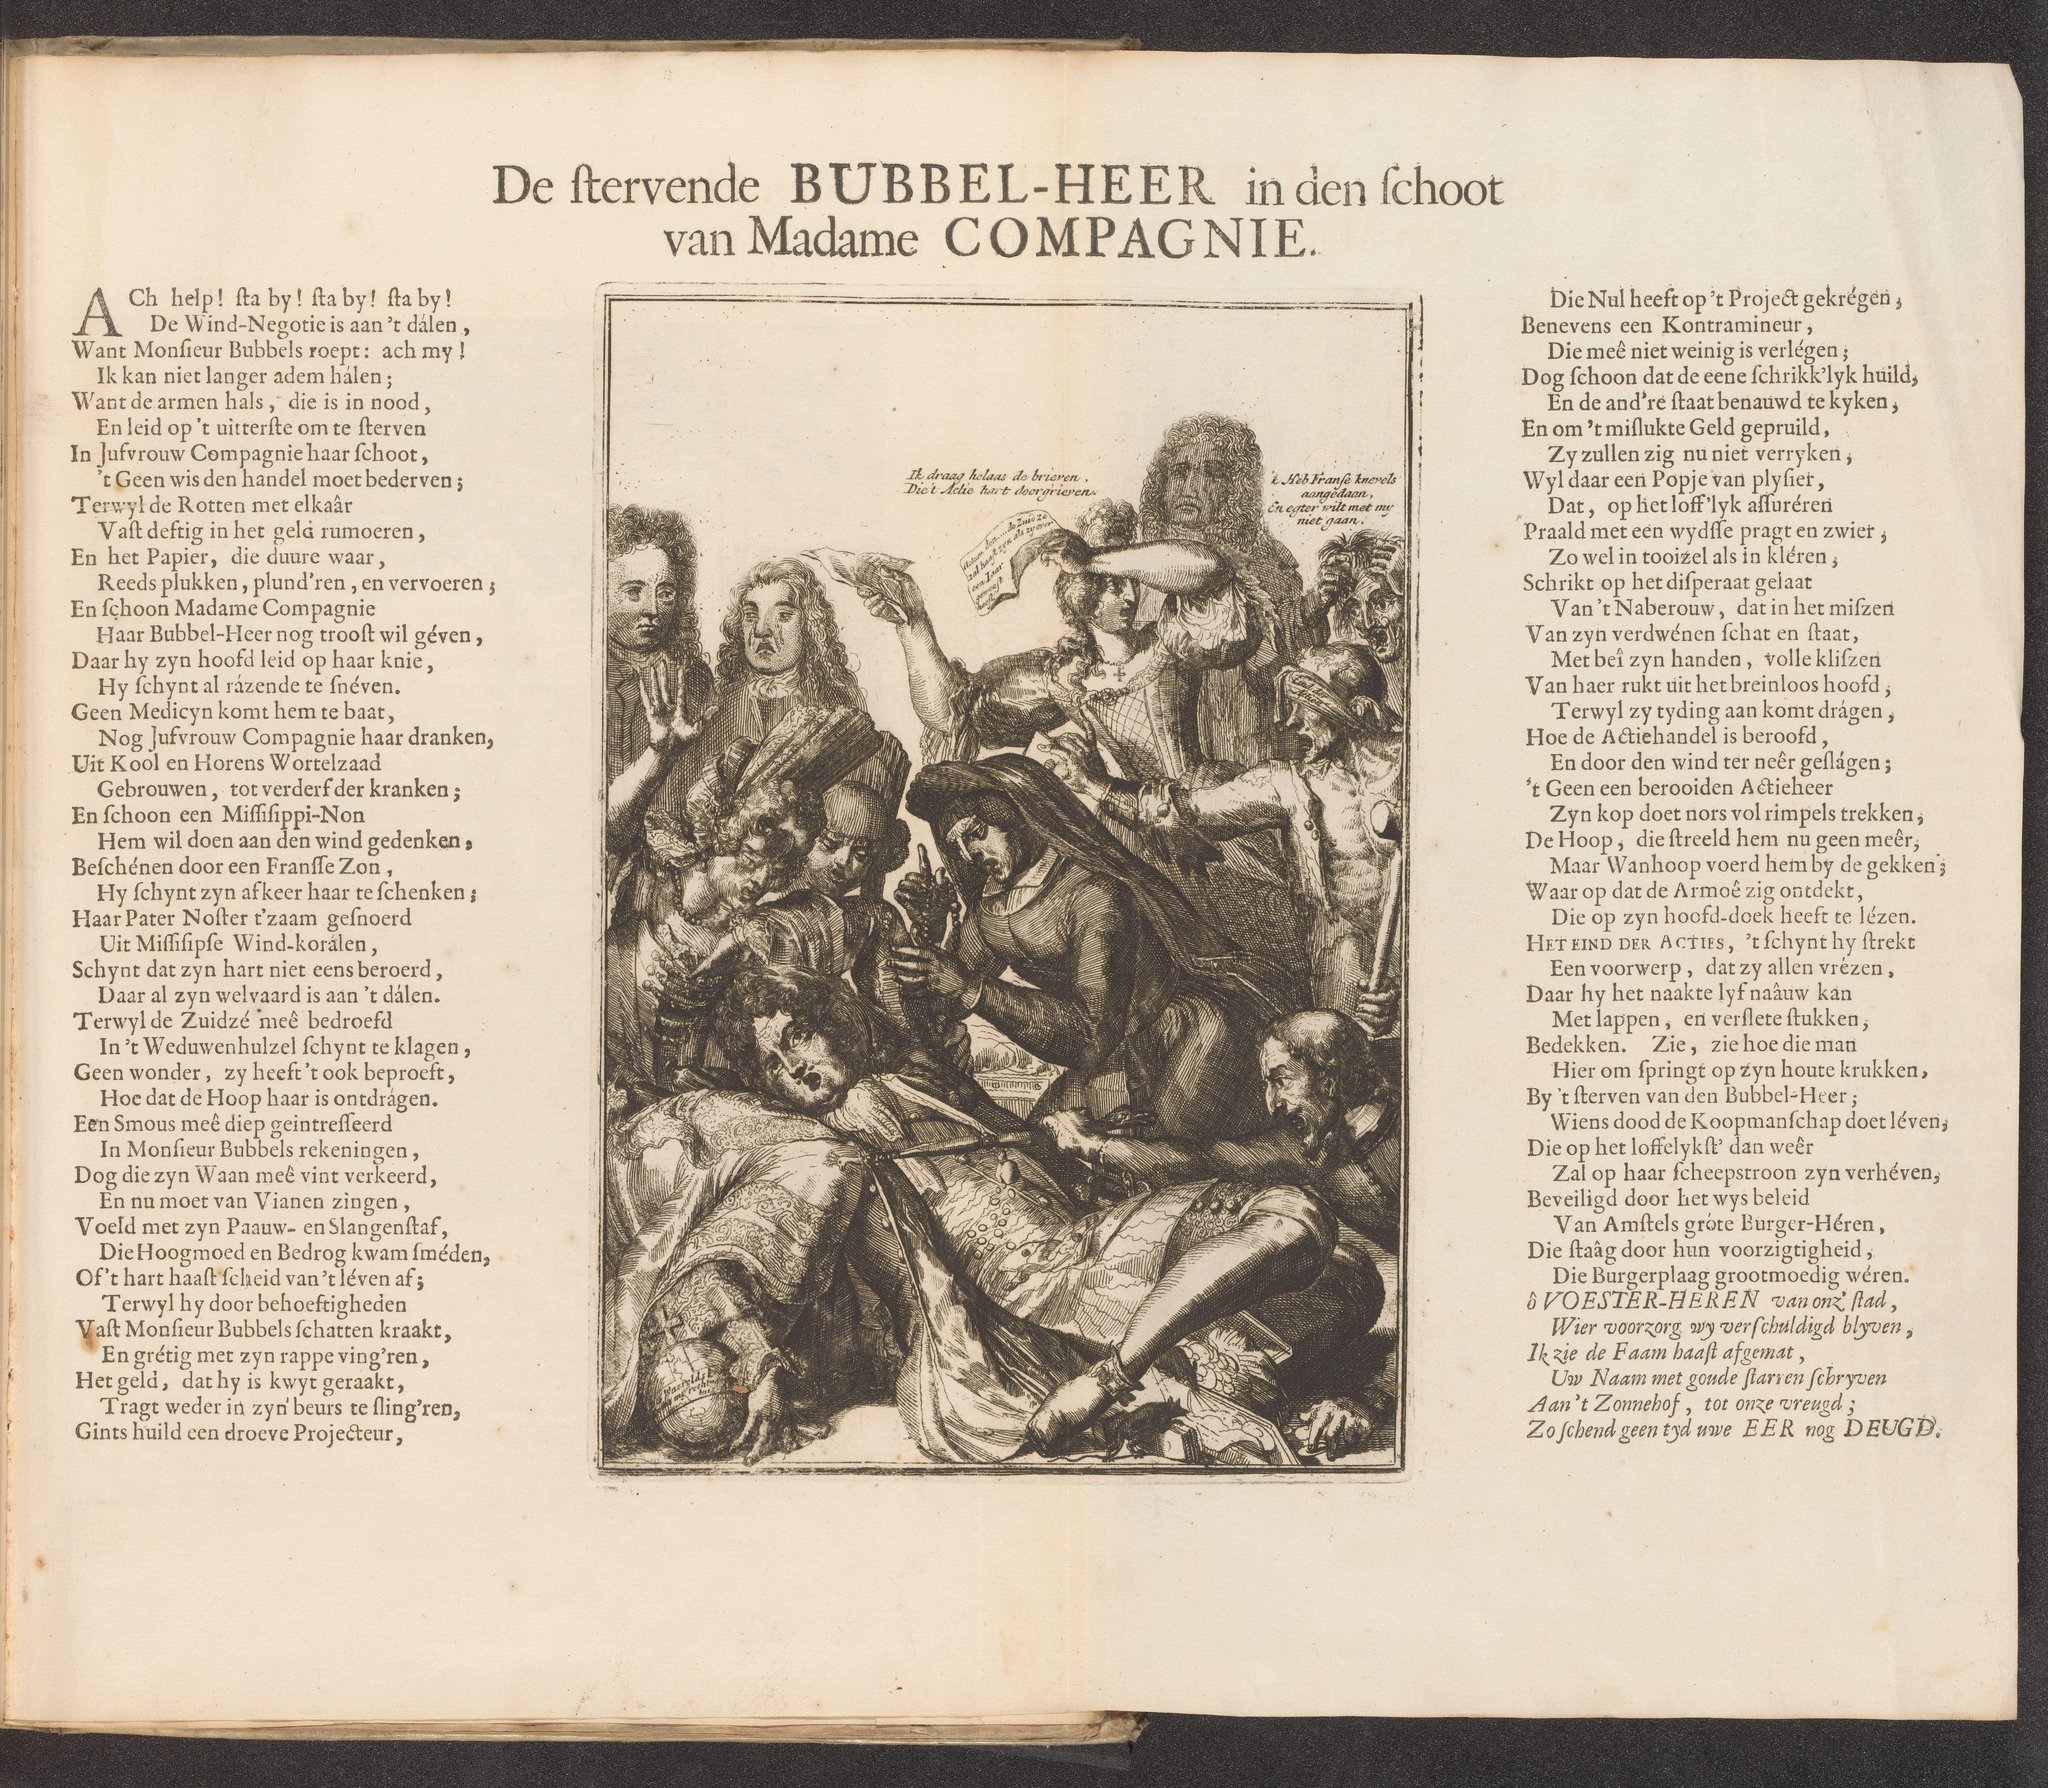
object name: cartoon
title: De stervende Bubbel-Heer in den schoot van Madame Compagnie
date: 1706-1707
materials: paper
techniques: etching, letterpress printing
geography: southern netherlands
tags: patient, sick person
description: De stervende windhandelaar of bubbelheer John Law achterover liggend in de schoot van Madame Compagnie wordt getroost door een non en een biechtvader. Met een vers aan weerszijden van de plaat. Prent in de gebonden eerste uitgave (304 B 10) van Het Groote Tafereel der Dwaasheid met spotprenten op de Windhandel of Actiehandel van 1720.